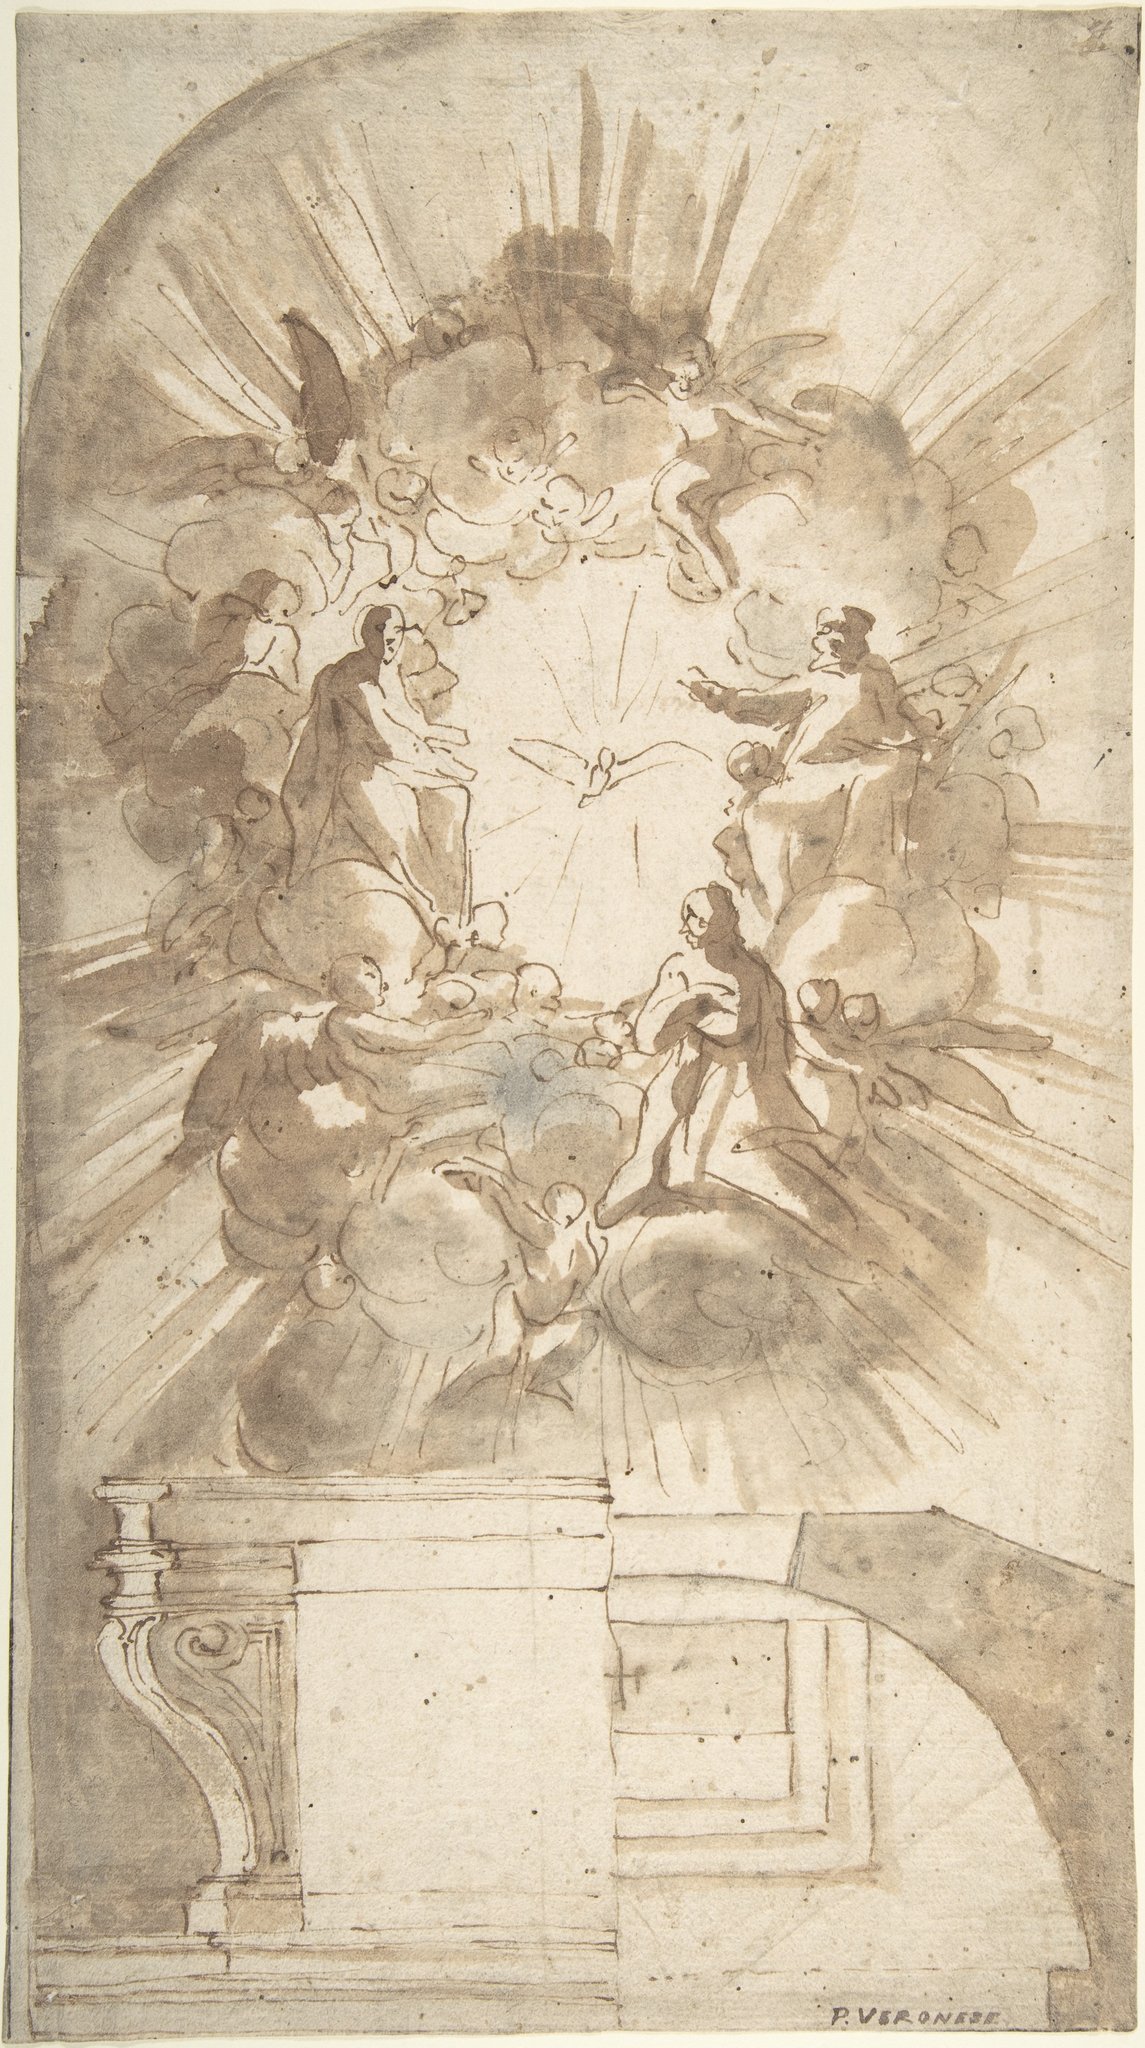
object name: drawing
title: Design for an Altar with a Celestial Subject Above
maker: anonymous, italian, 16th century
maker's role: artist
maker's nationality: italian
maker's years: 1550-1600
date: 1501-1600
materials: ink, drawing material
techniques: brush, pen, wash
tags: altars